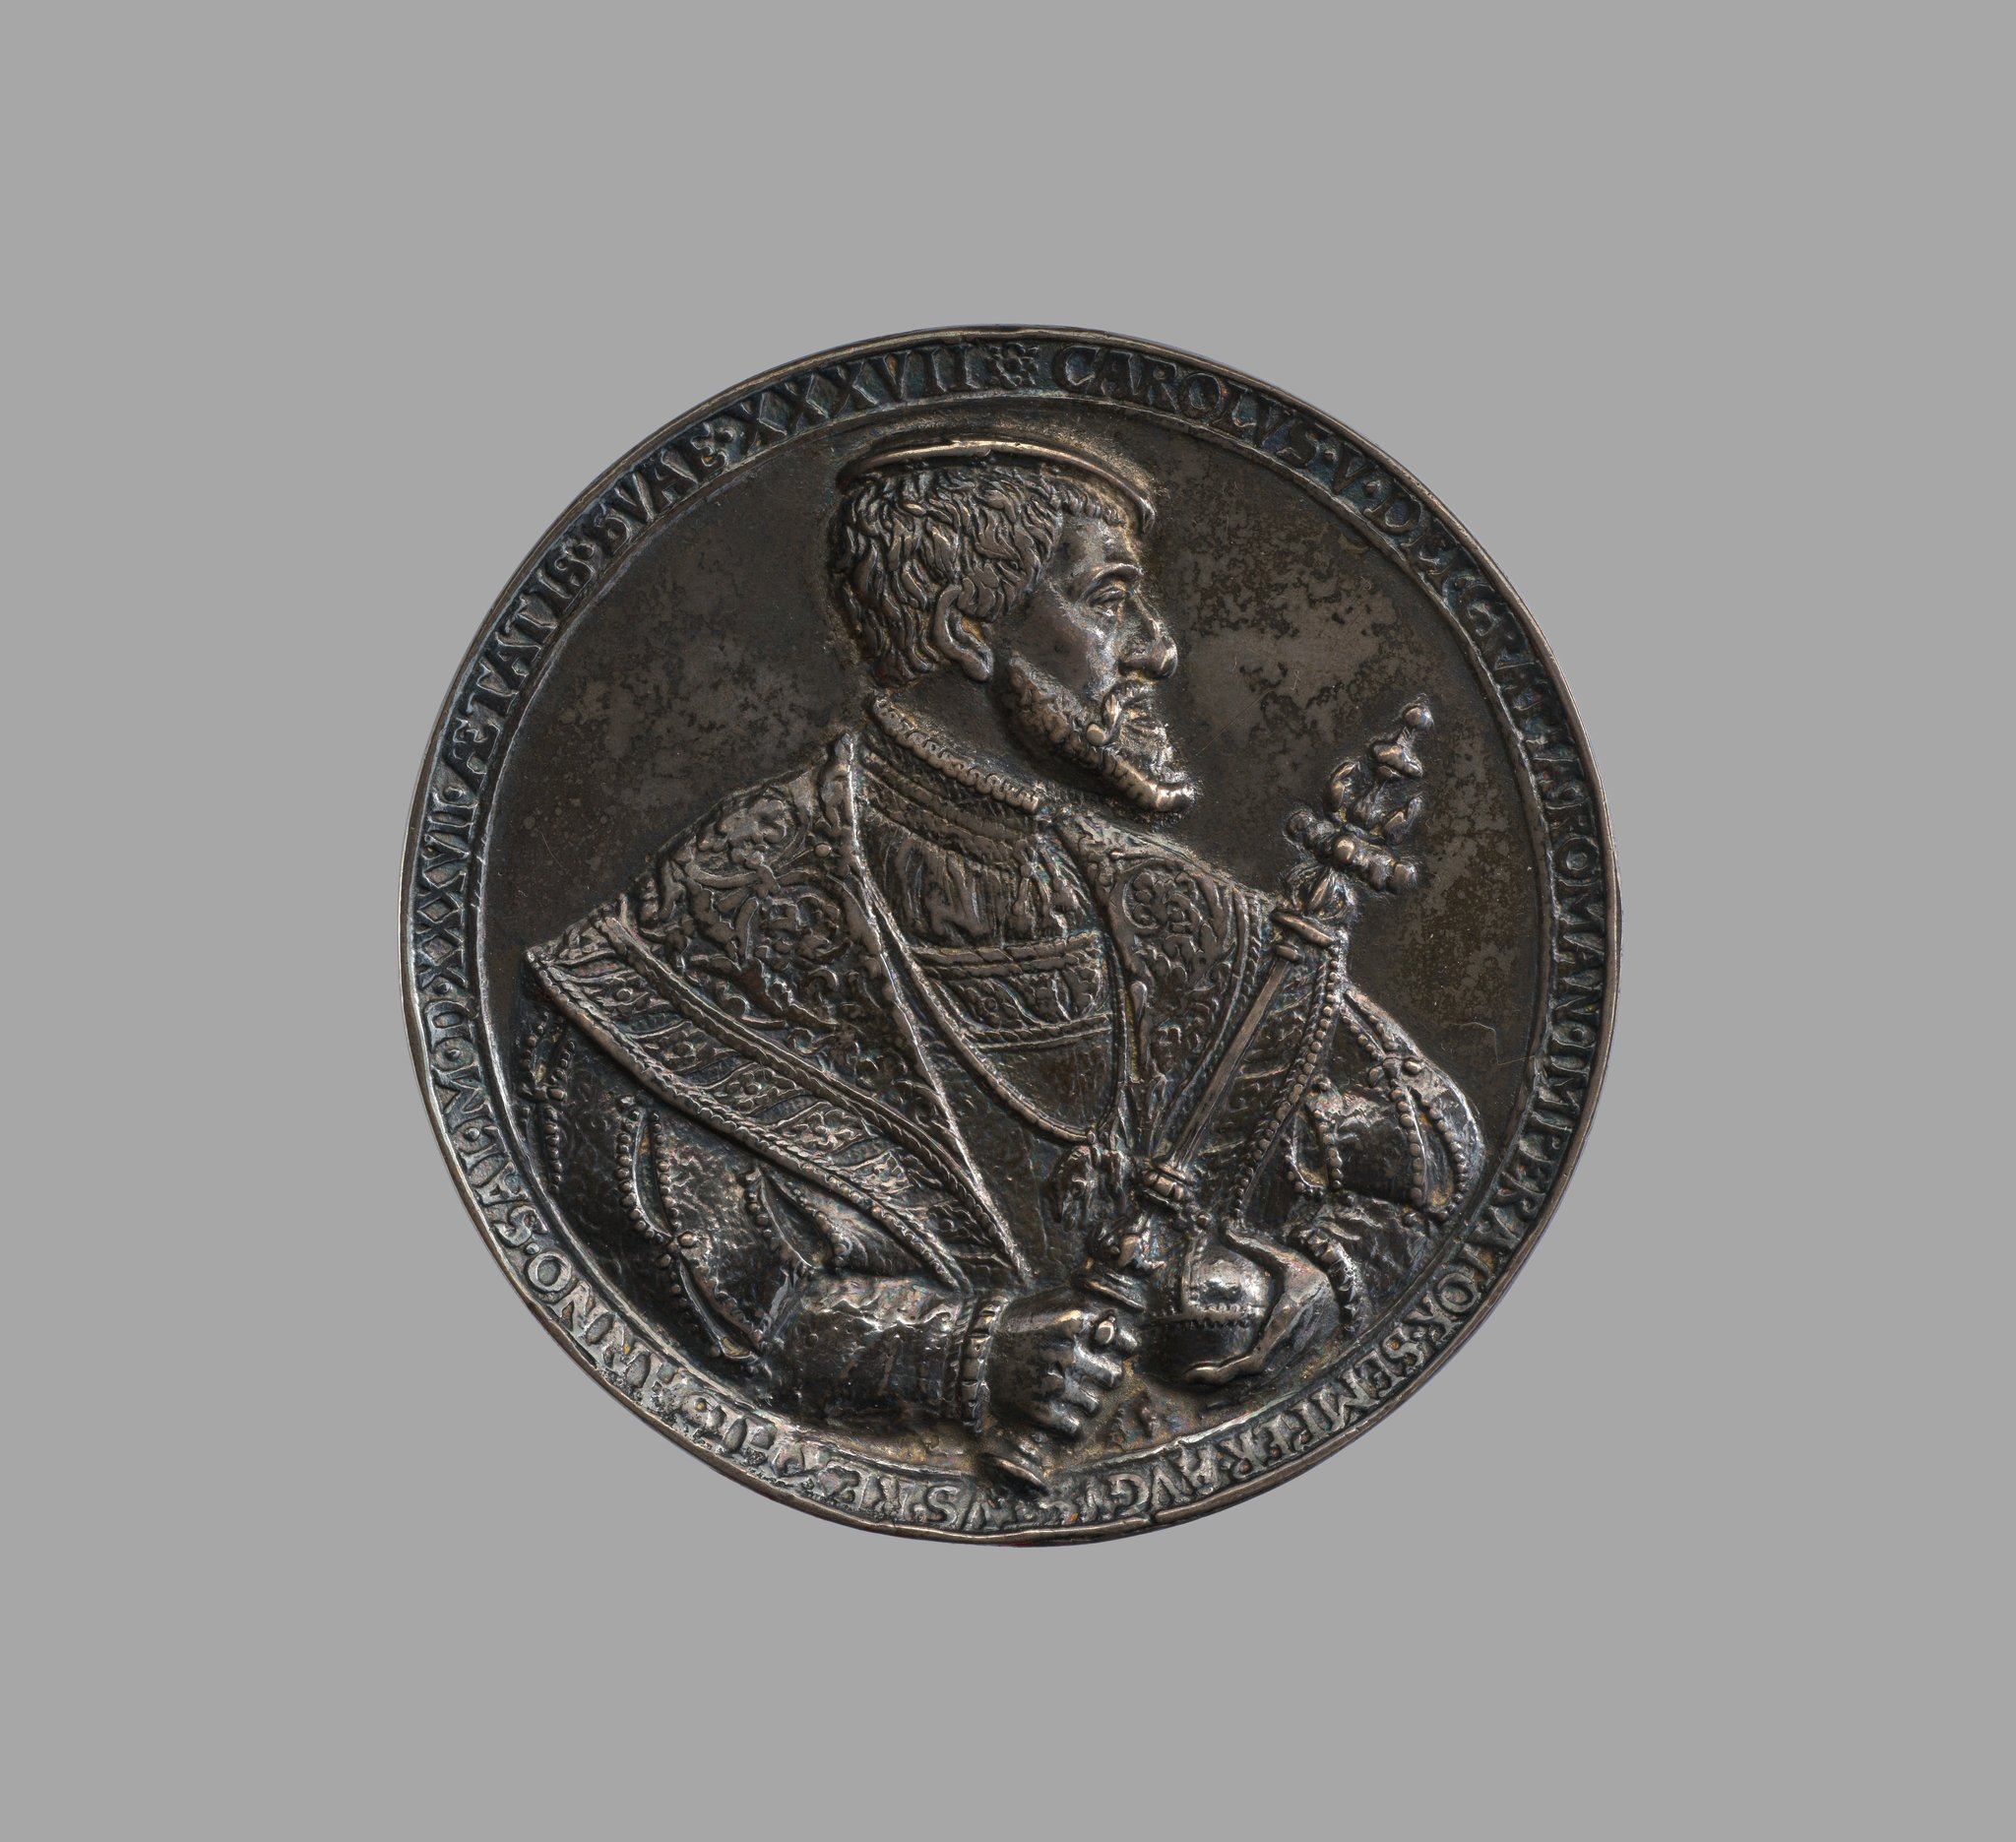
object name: medal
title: Emperor Charles V (1500–58, r. 1519–58)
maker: hans reinhart the elder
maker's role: artist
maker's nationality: german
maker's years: 1500-1581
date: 1537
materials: silver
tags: kings,coat of arms